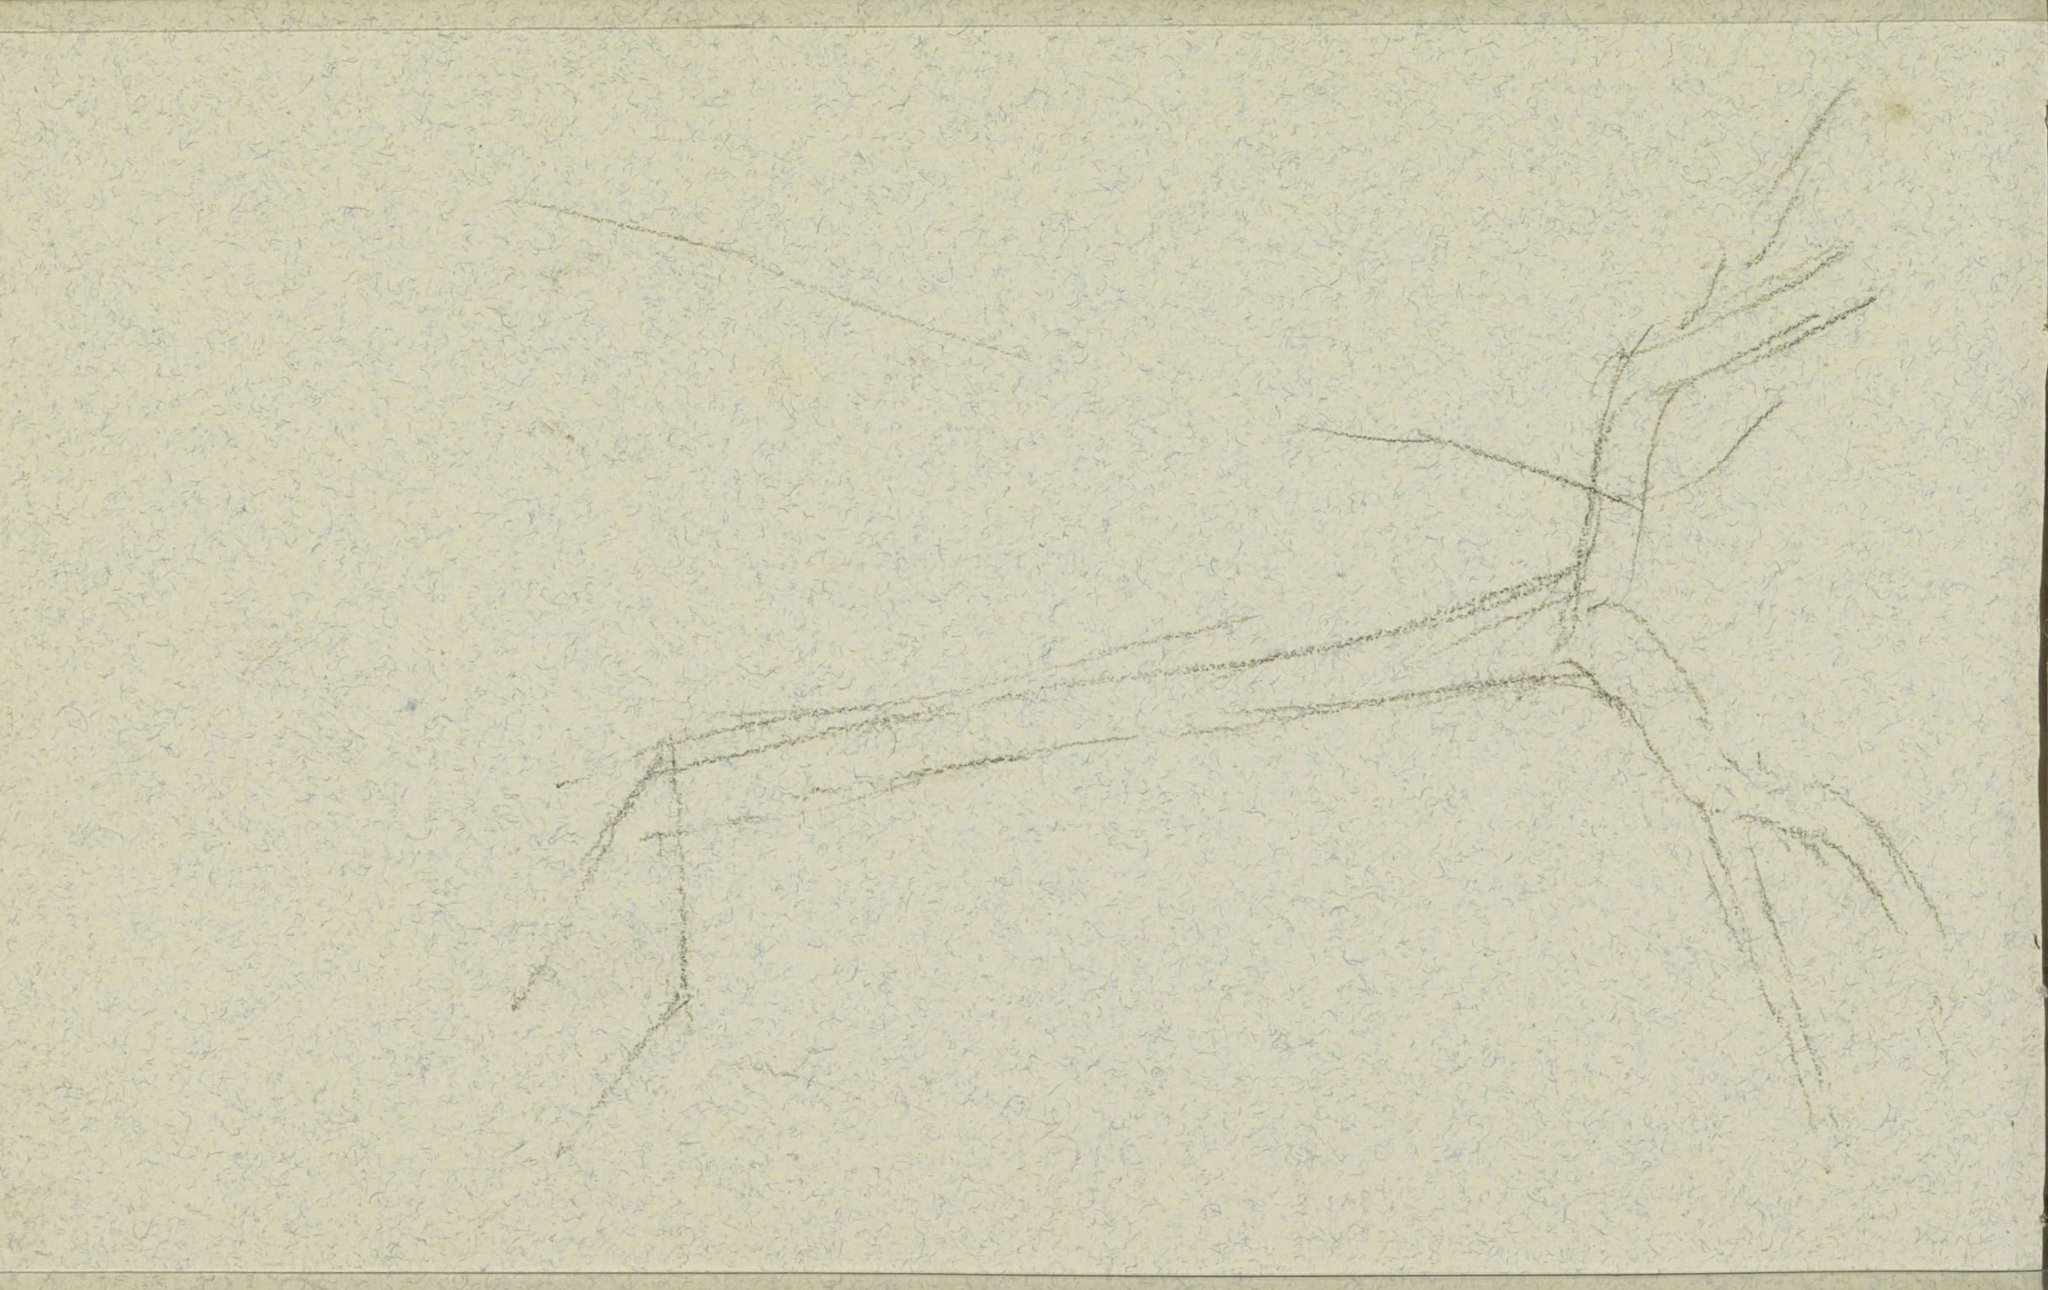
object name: sketchbook leaf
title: Boomstam en wortels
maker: jozef israëls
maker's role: draughtsman, painter, print maker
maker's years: 1824-1911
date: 1834-1911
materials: chalk, paper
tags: trees (+ stem, trunk)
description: Blad 29 verso uit een schetsboek met 37 bladen.